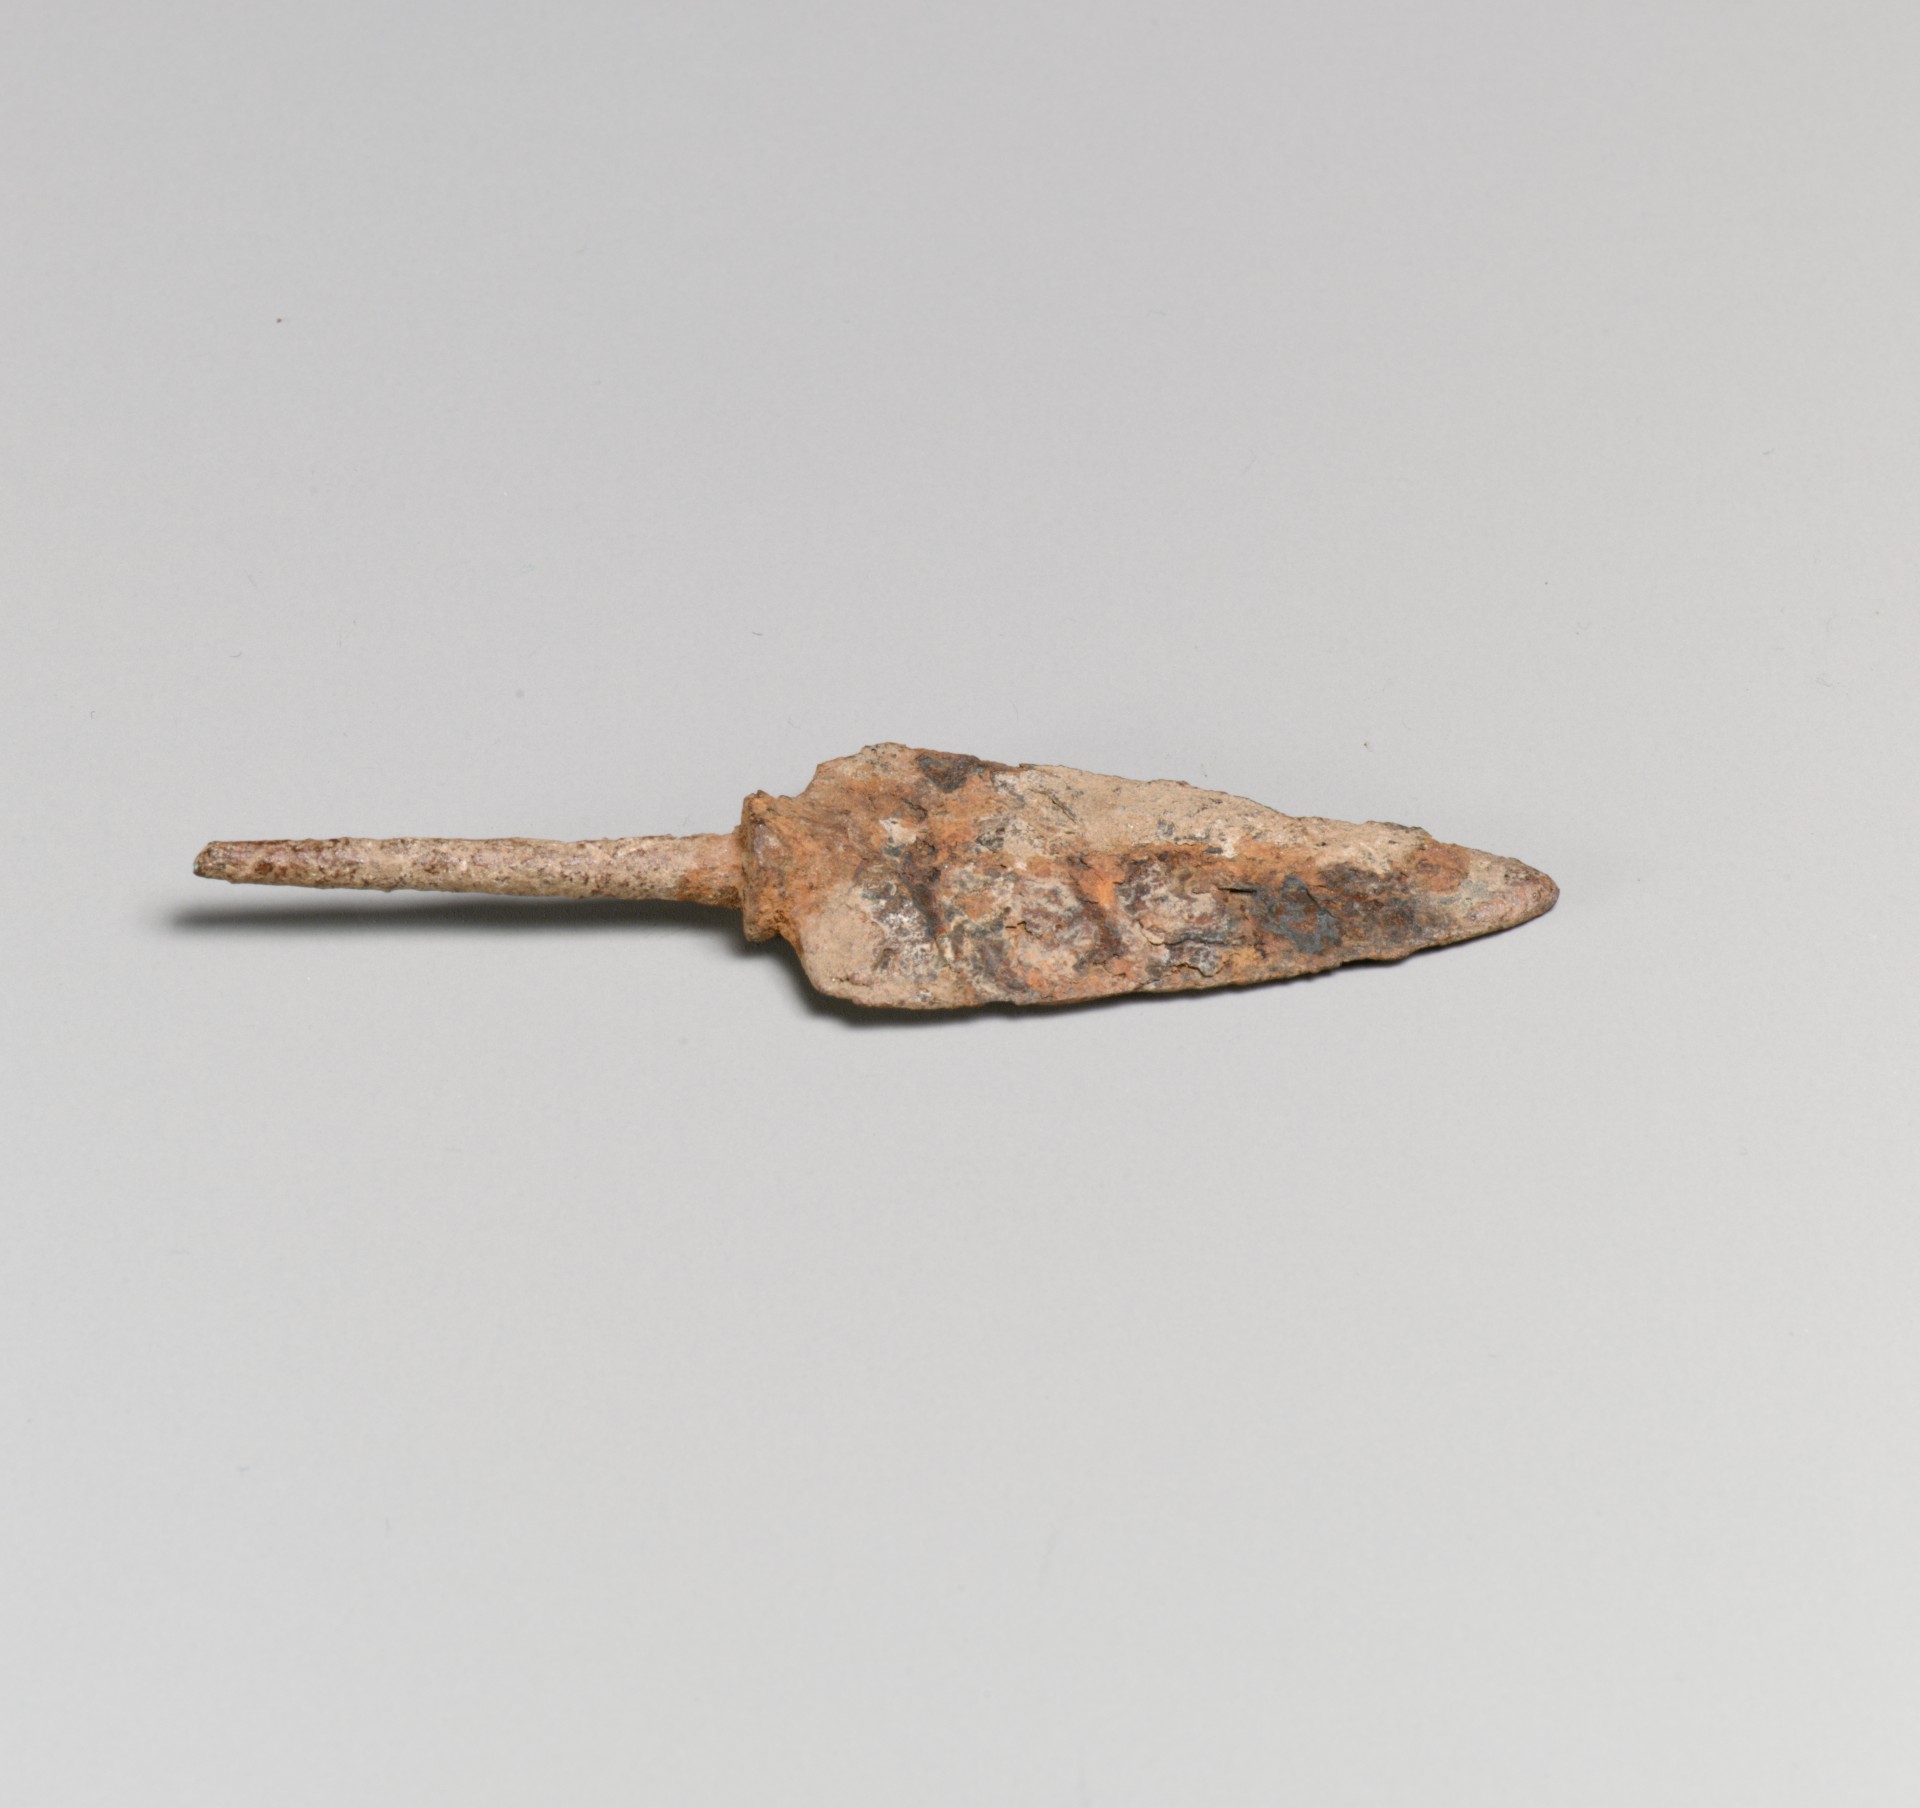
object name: arrowhead with tang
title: Arrowhead ? with tang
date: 7000 BCE-330 CE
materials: iron